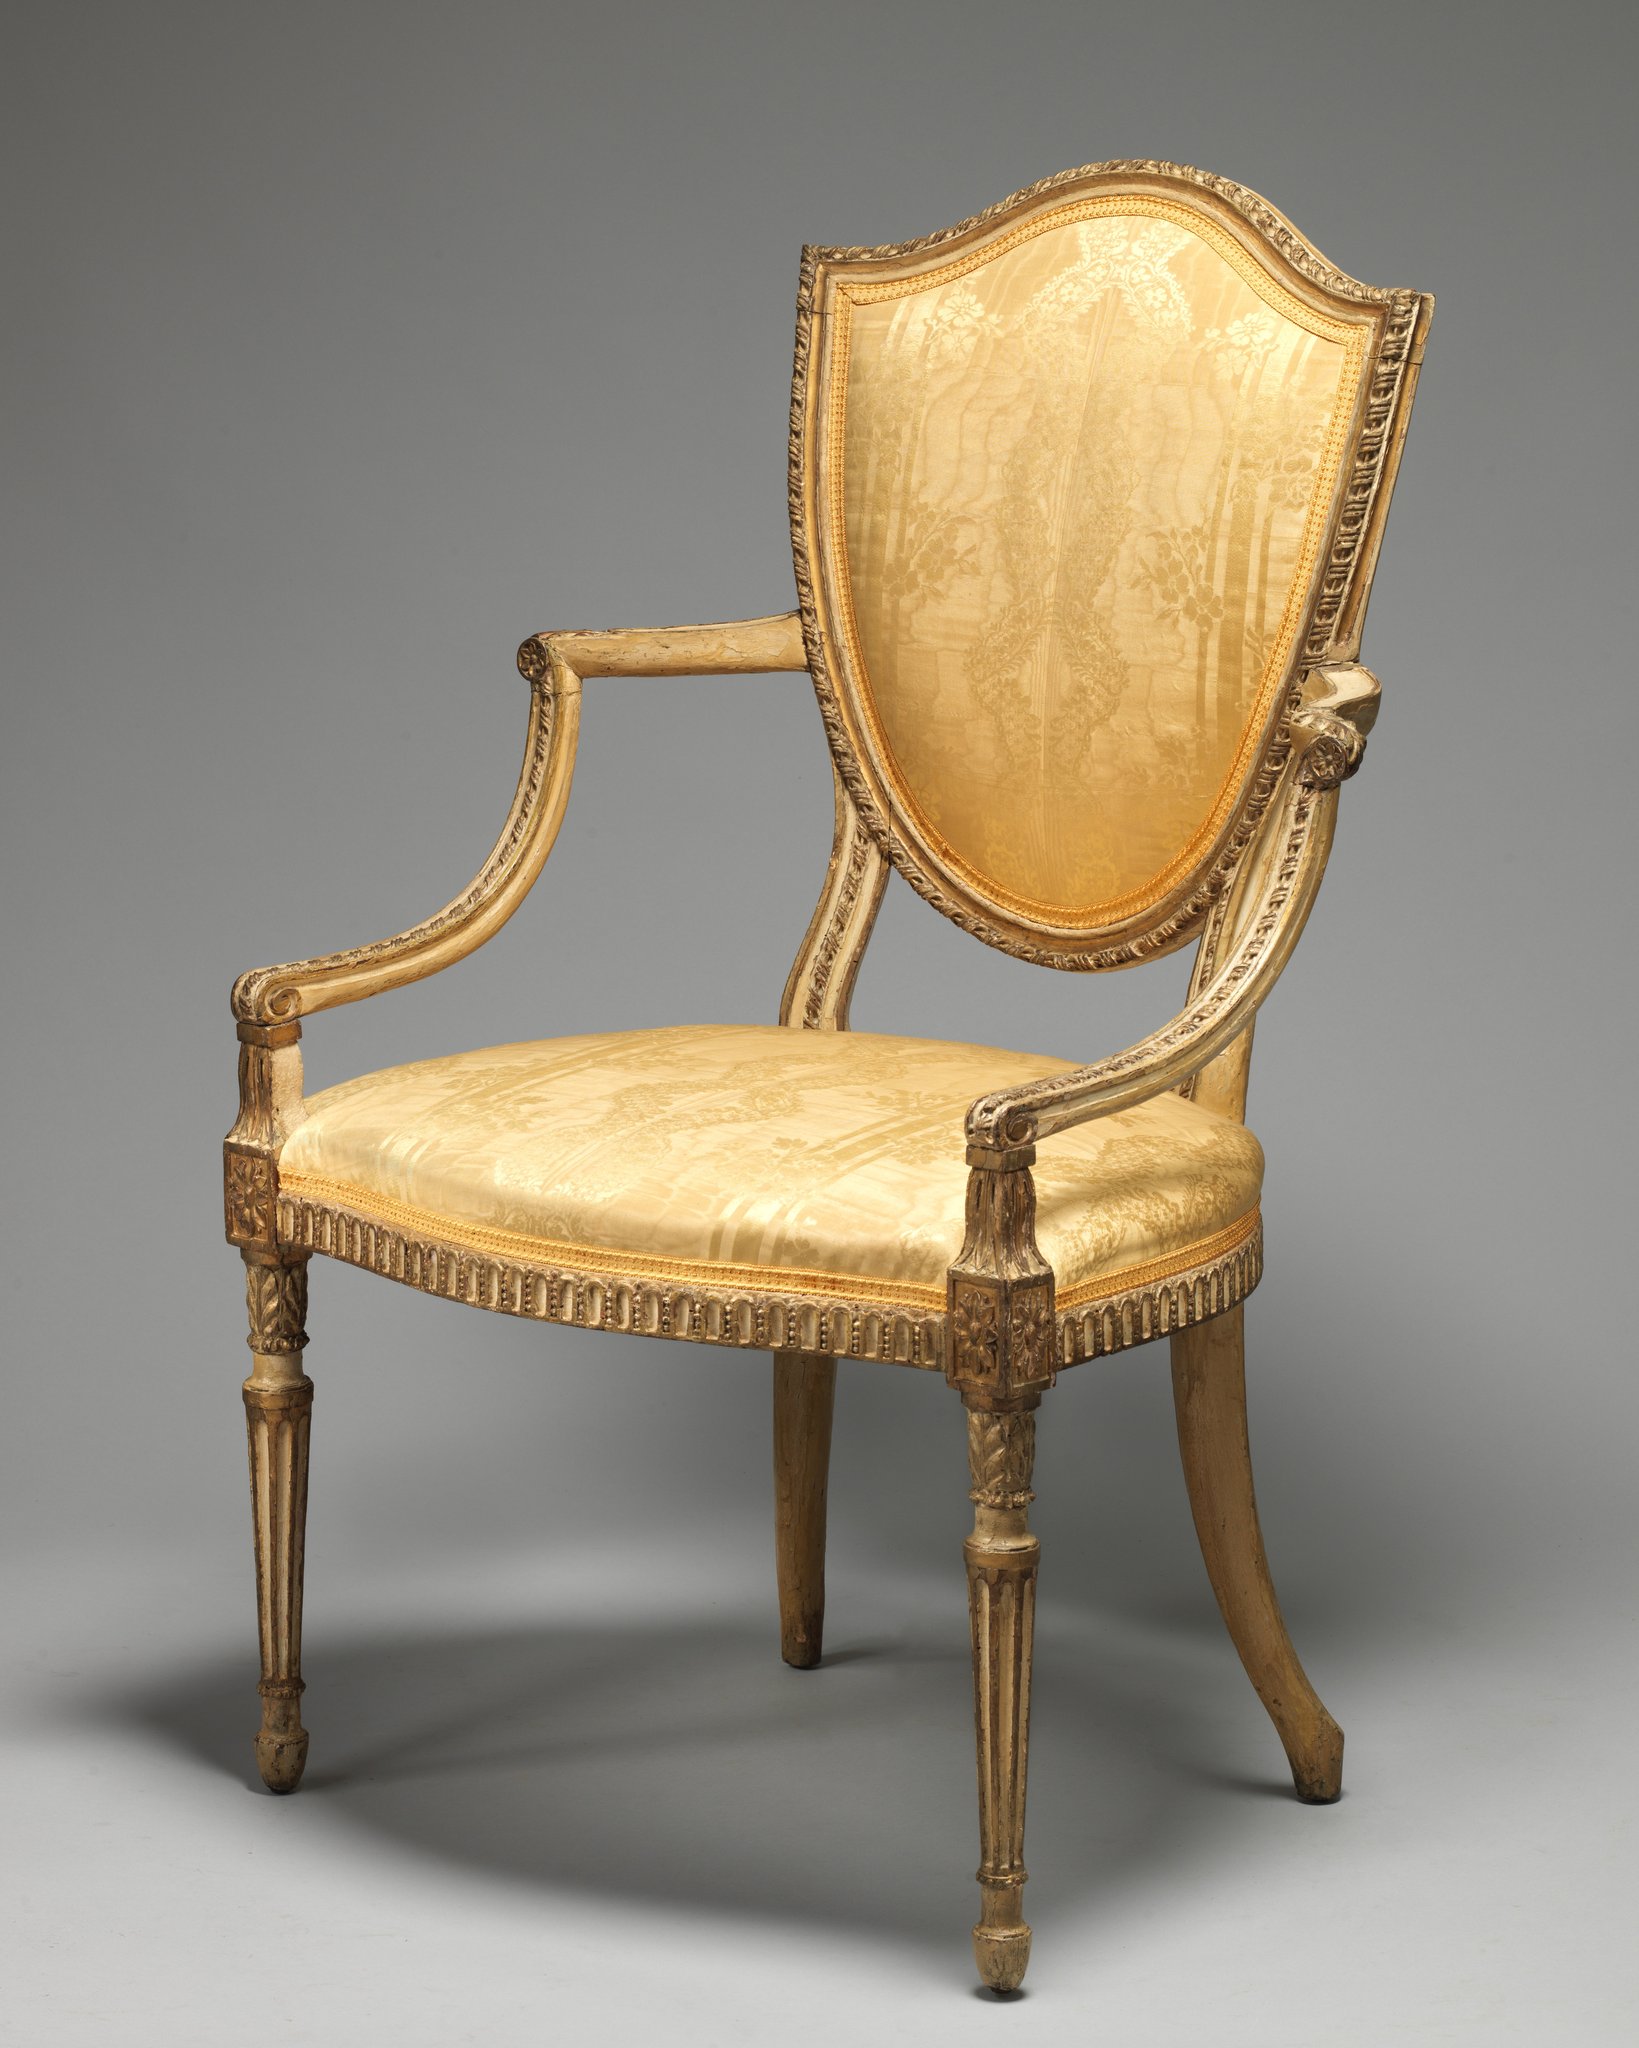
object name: armchair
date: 1790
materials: wood, gilt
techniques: painting